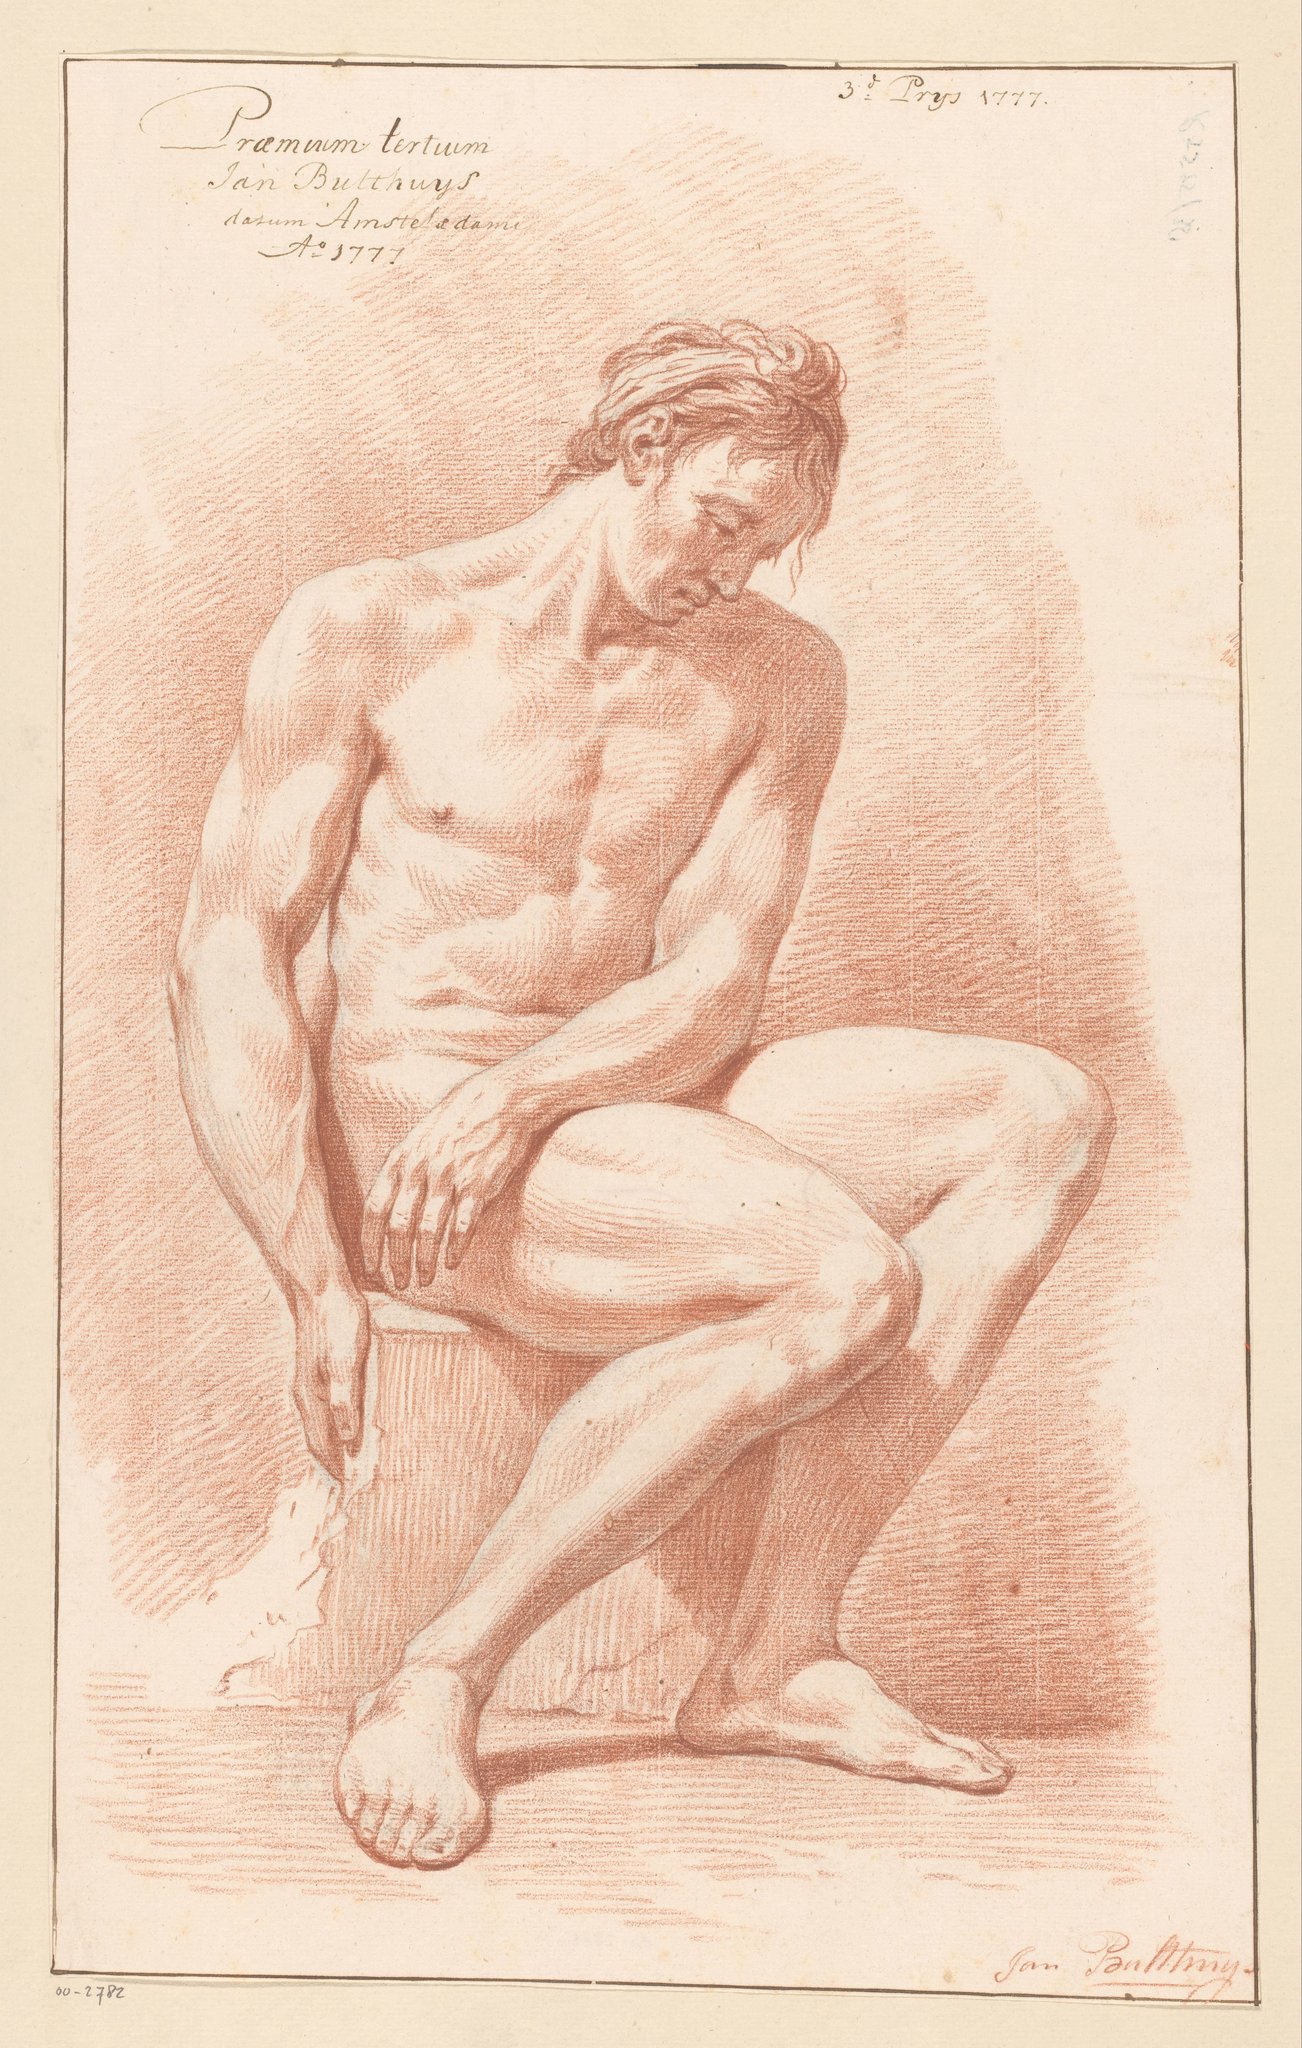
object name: drawing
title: Zittend mannelijk naakt, van voren gezien (3e prijs 1777)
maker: jan bulthuis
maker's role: draughtsman, print maker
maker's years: 1750-1801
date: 1777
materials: chalk, charcoal, paper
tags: sitting figure (+ nude human being)